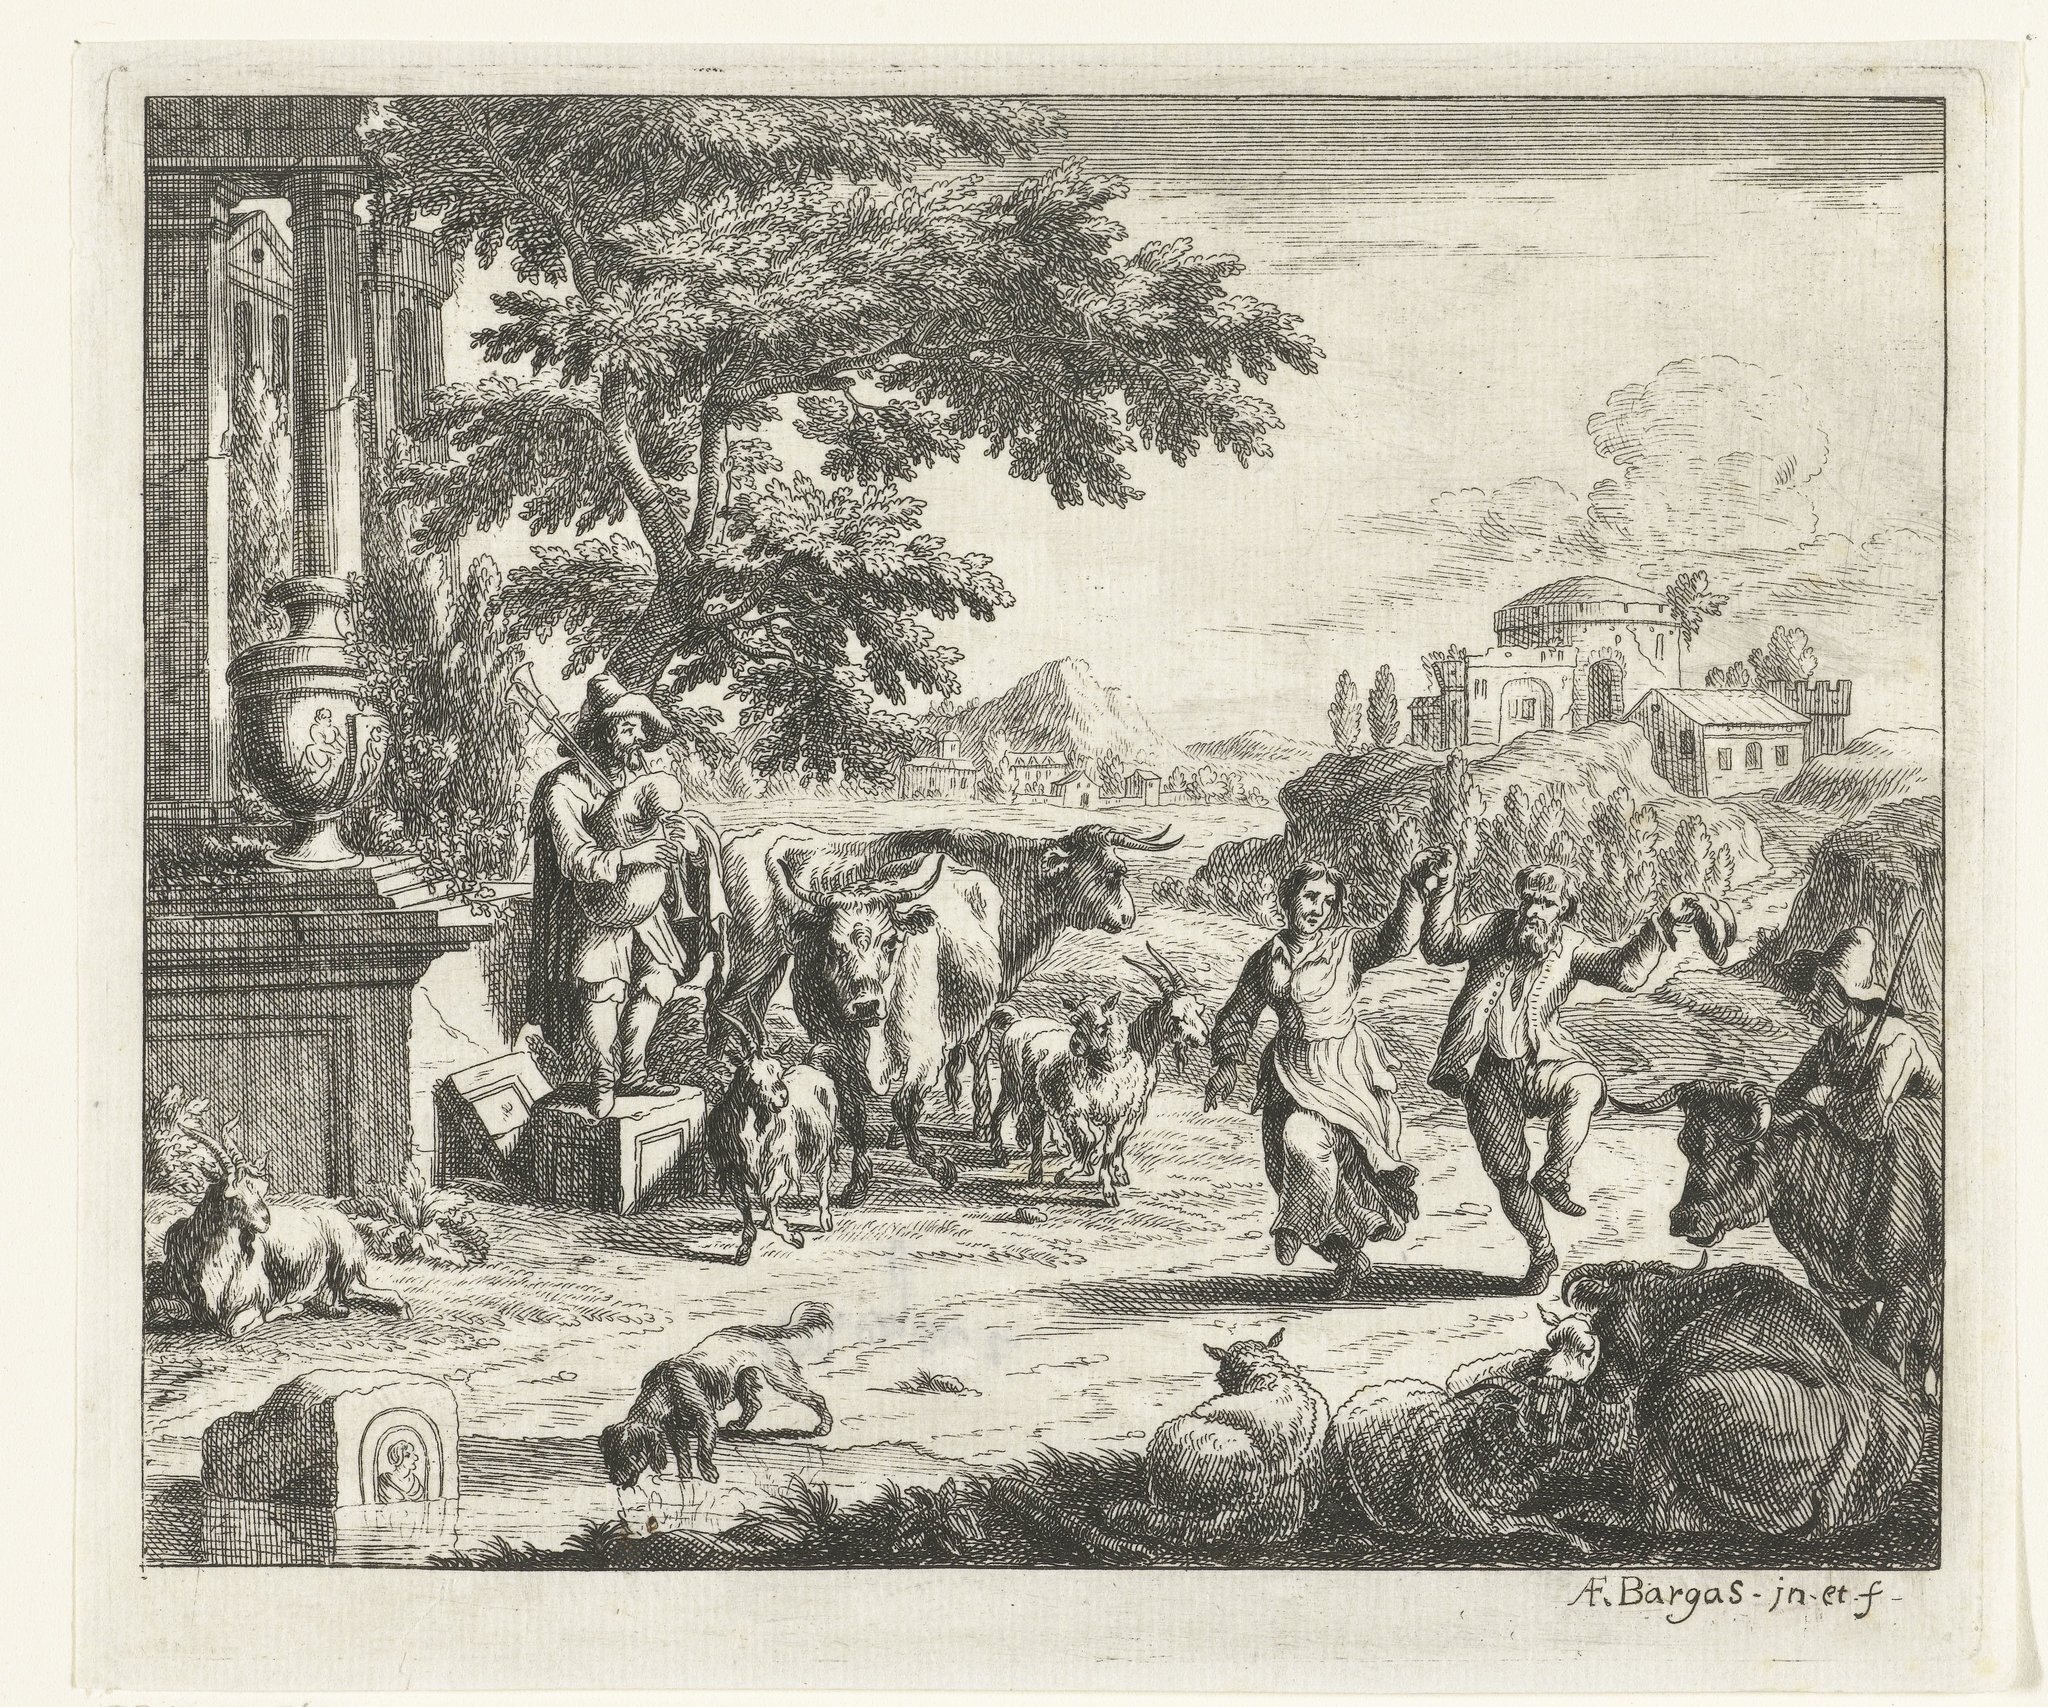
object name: print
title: Landschap met dansende man en vrouw en doedelzakspeler bij ruïnes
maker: franciscus de bargas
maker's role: draughtsman, painter, print maker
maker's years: 1667-1723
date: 1660-1699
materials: paper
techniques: etching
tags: dancing, one person playing wind instrument, bagpipe, musette, one pair dancing; man and woman dancing as a couple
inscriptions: collector's mark: Lugt 240